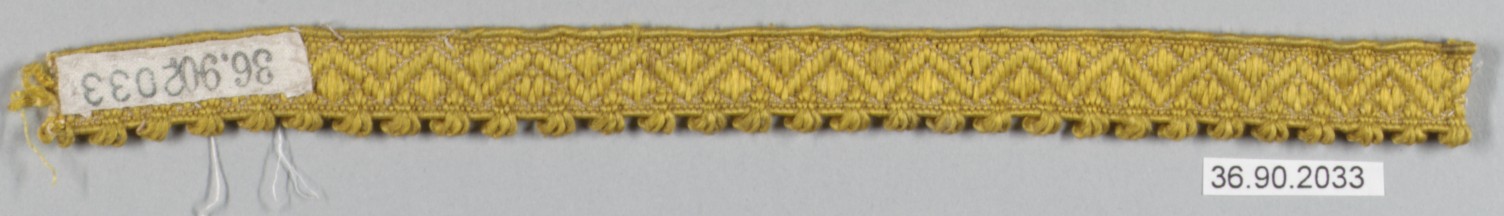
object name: fringe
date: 1767-1800